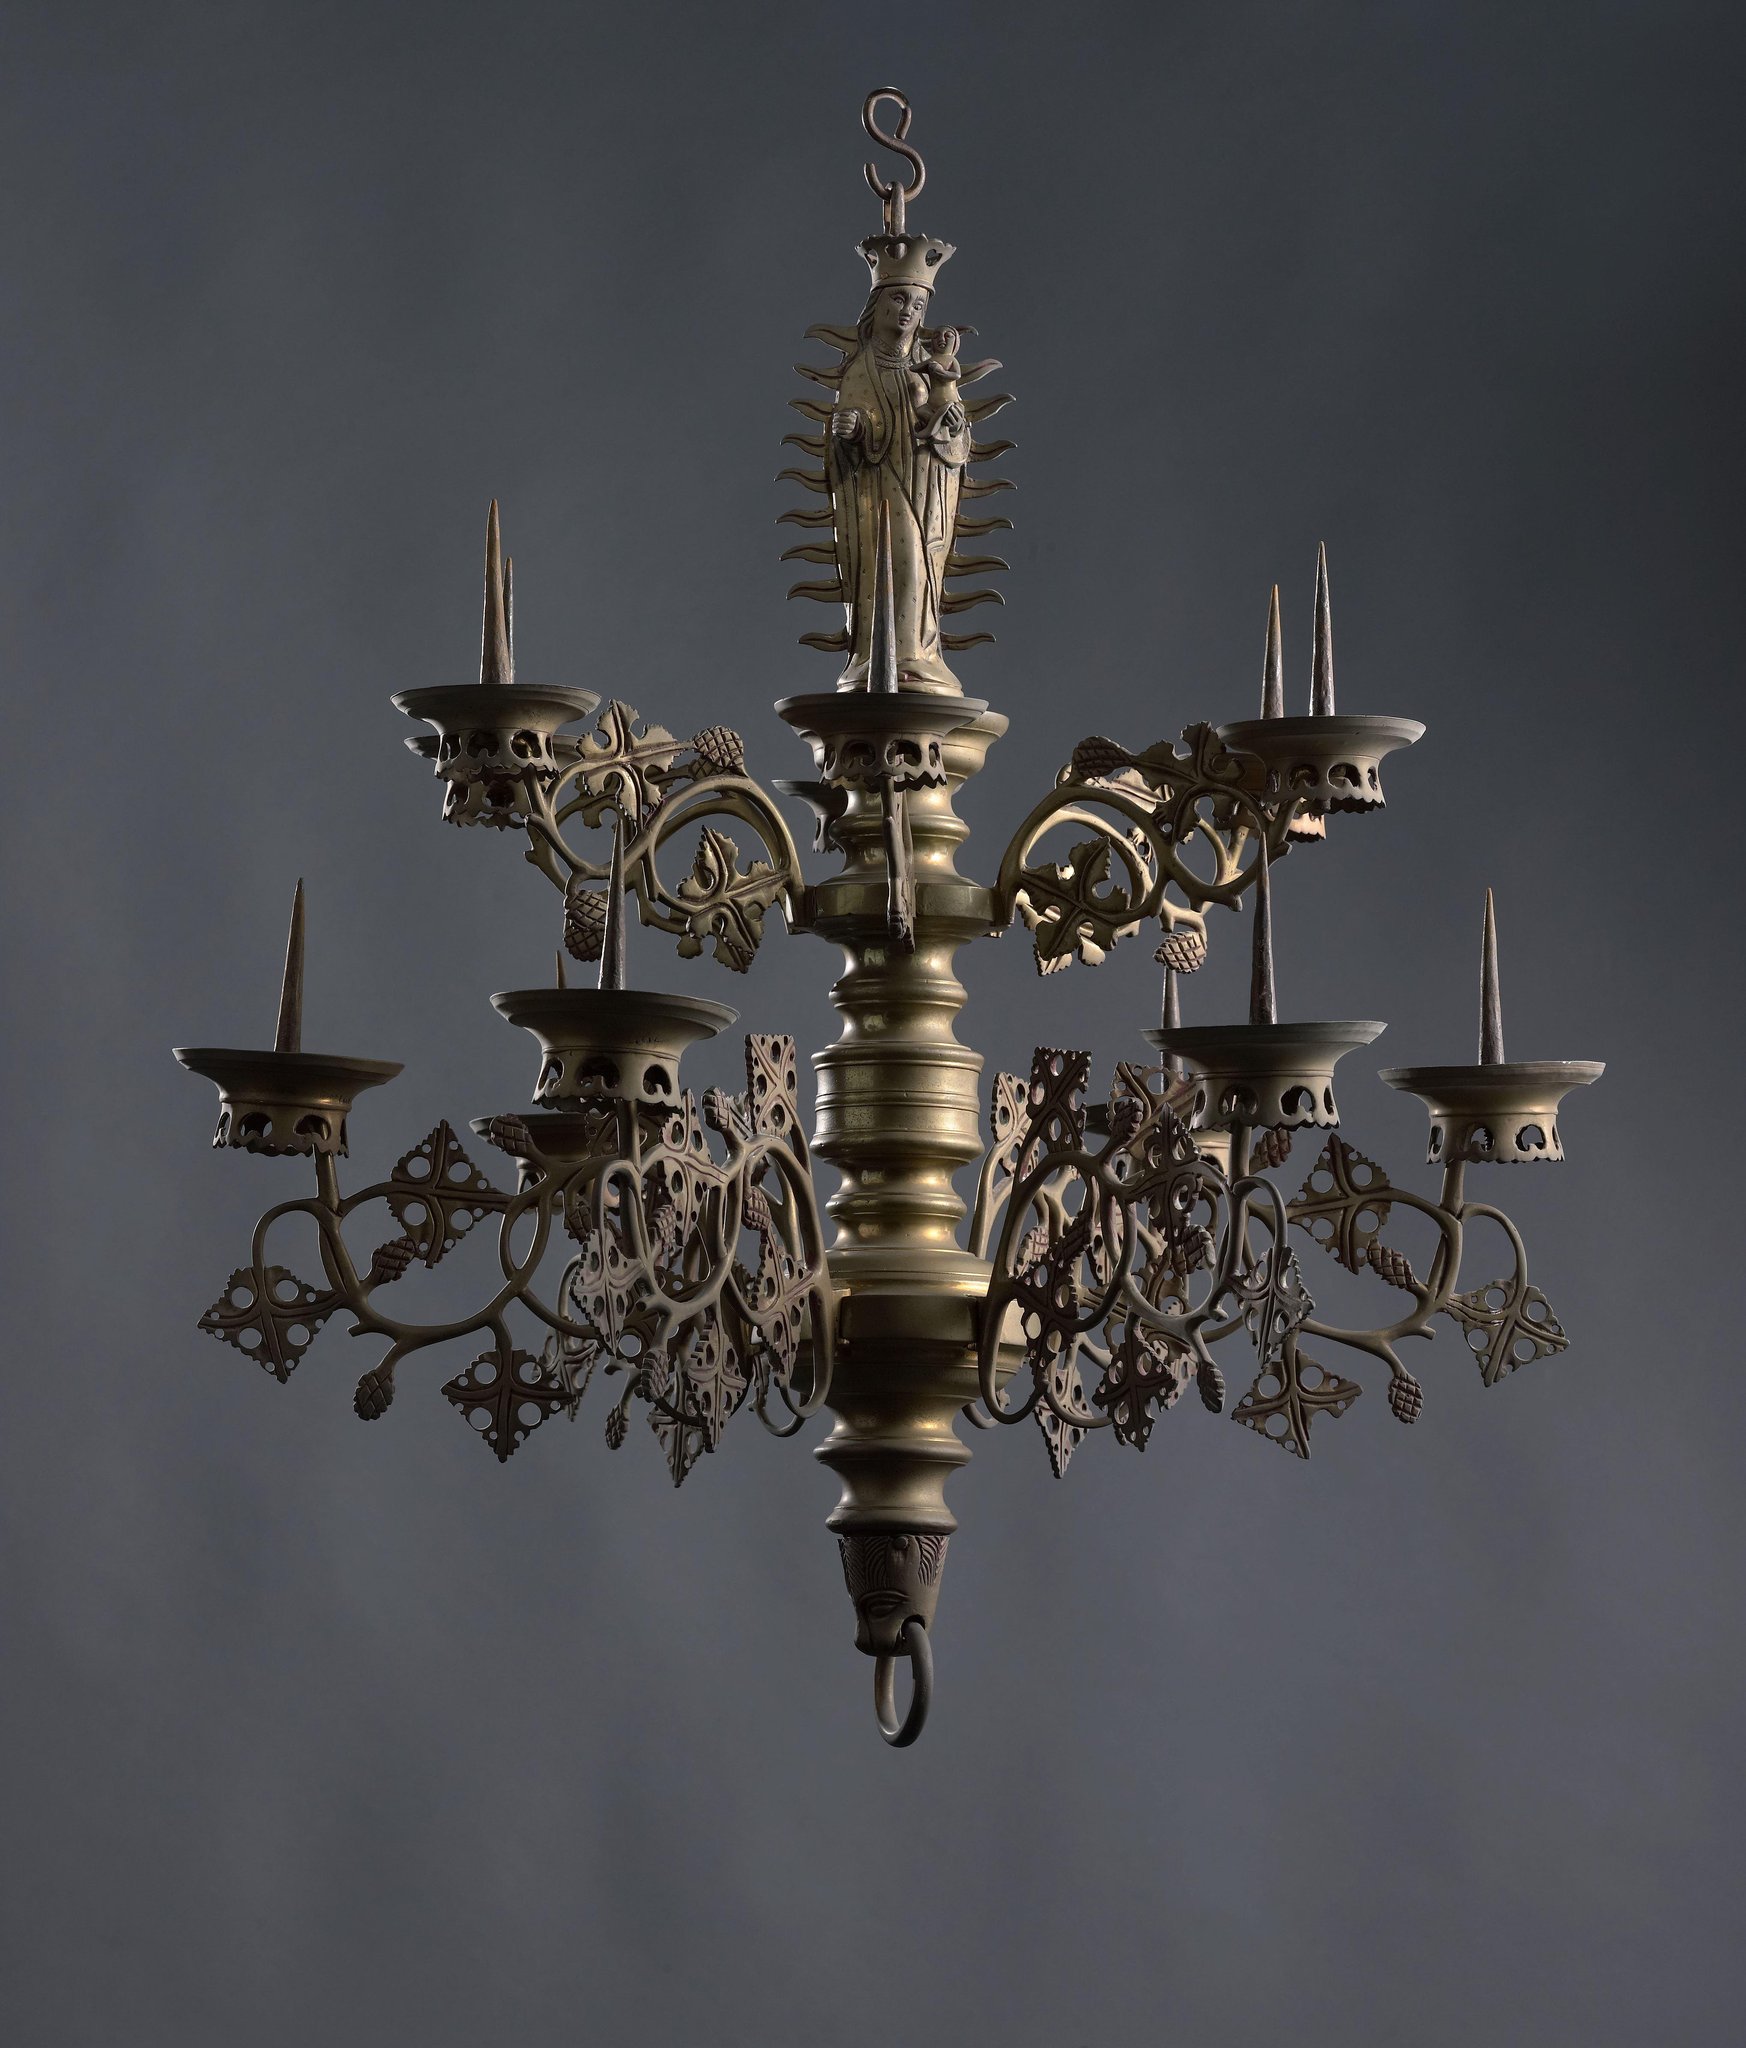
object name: chandelier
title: Stam van kaarsenkroon met Maria met Christuskind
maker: Anonymous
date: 1475-1500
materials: brass, iron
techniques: casting, punching, riveted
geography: southern netherlands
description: Het voorwerp bestaat uit een ijzeren stang met een ijzeren haak en de volgende gegoten delen: de Mariafiguur, de aan haar arm geklonken rechterhand, haar op overeenkomstige wijze geklonken linkerhand met het Christuskind, de op haar hoofd geklonken kroon, de stam, de geklonken leeuwenkop, de trekring. De staande Mariafiguur is omgeven door een stralenkrans. Haar kleed en mantel zijn versierd met geponste stermotieven. Mantelsluiting en halsketting zijn eveneens geponst aangegeven. De overwegend holrond geprofileerde stam heeft twee standringen met telkens zes inkepingen, die gemerkt zijn met één tot en met vijf inkepingen. De laatste inkeping per ring is ongemerkt. Bij de Mariafiguur ontbreekt de scepter.